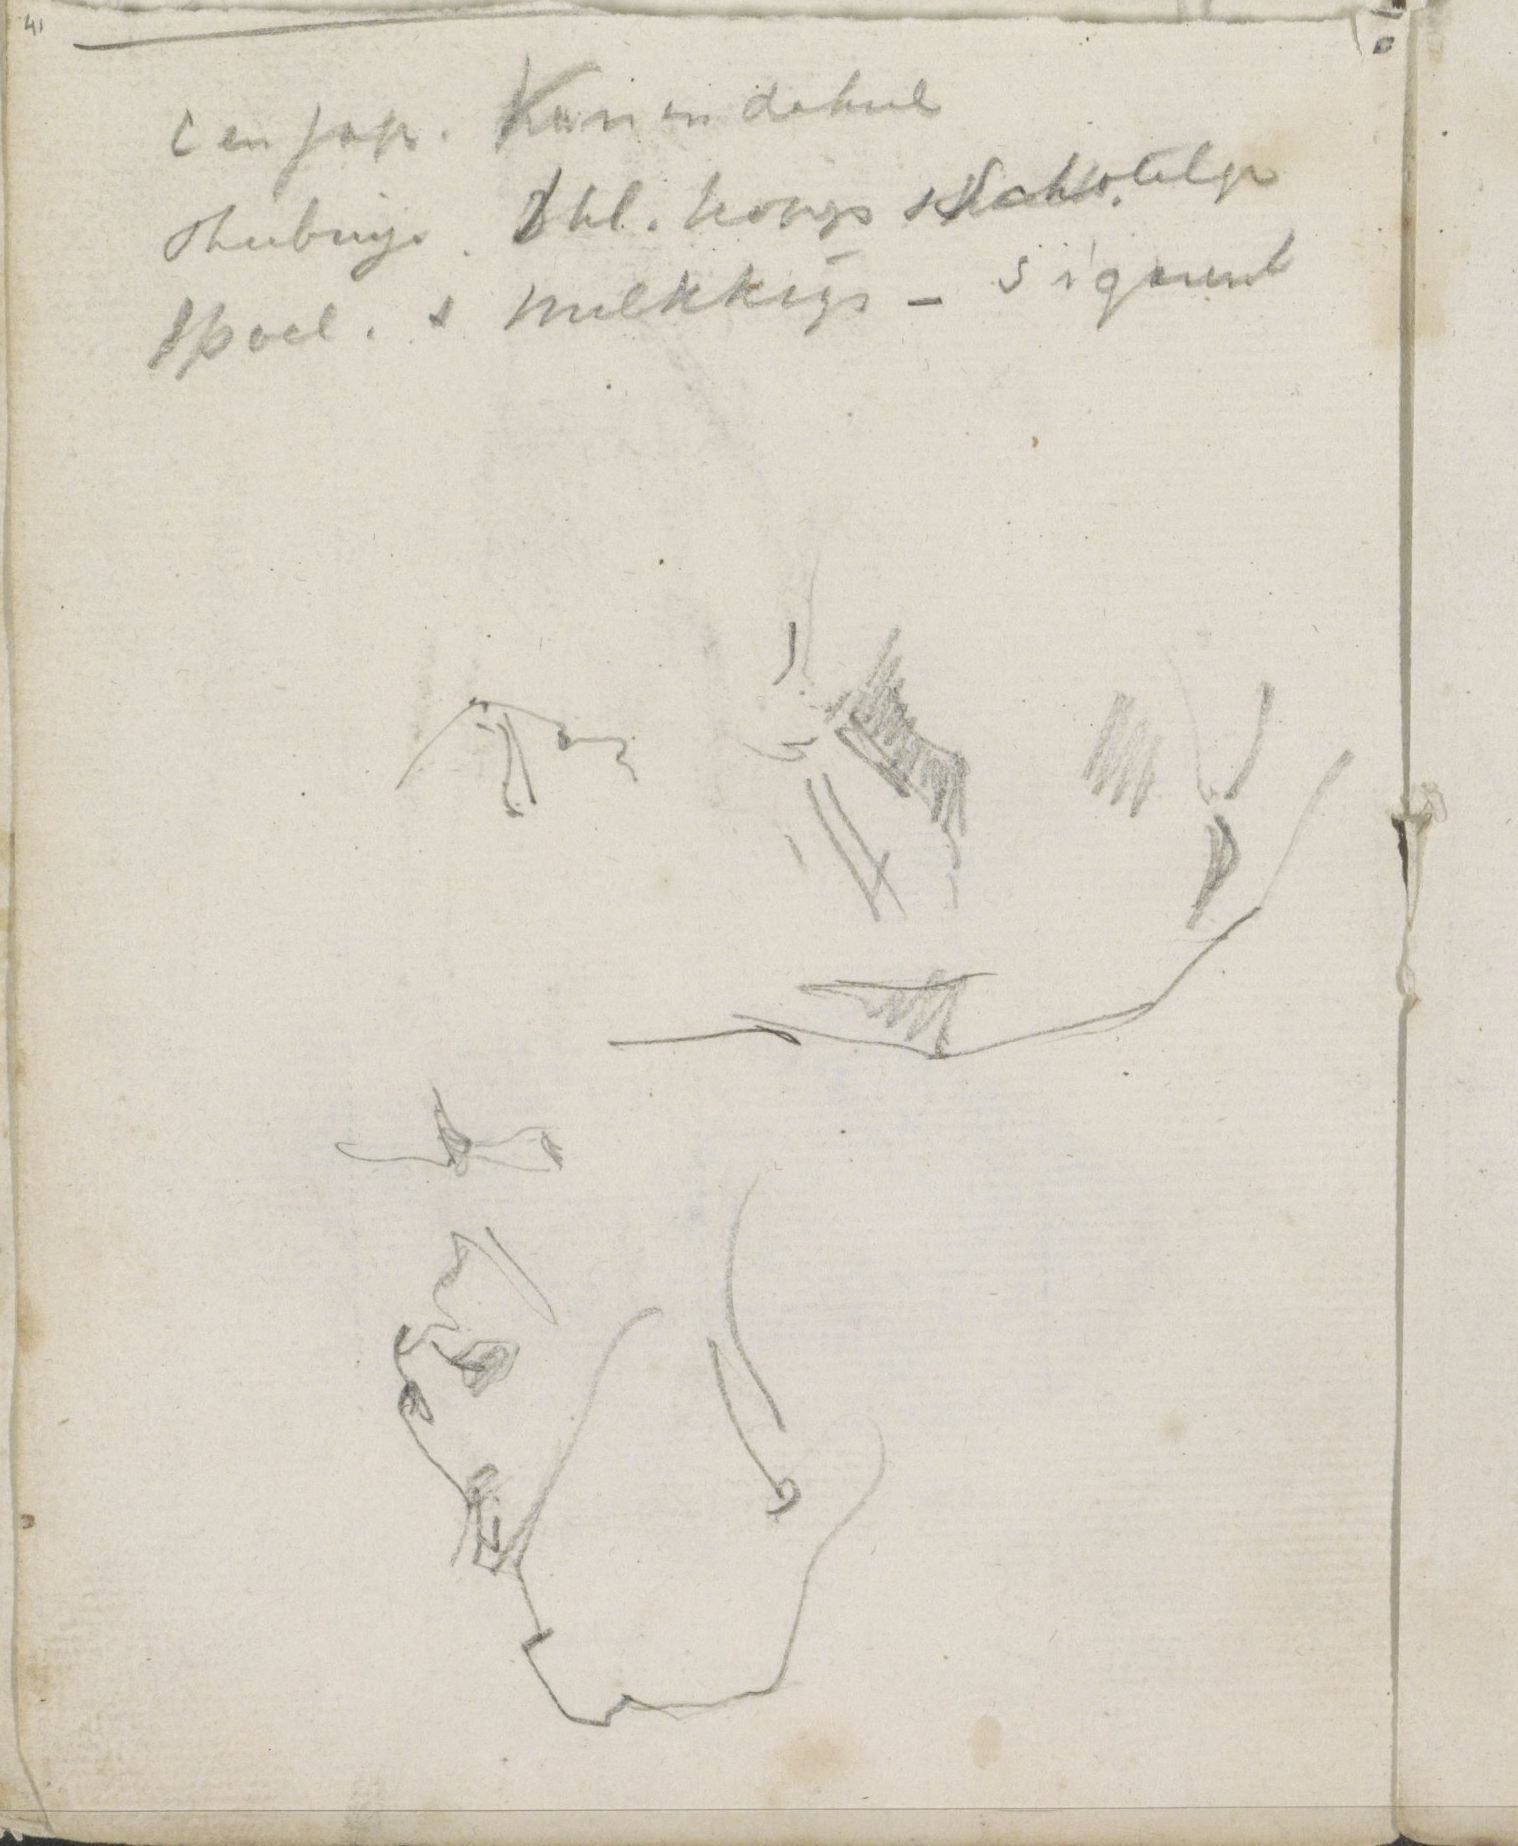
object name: sketchbook leaf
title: Studieblad, onder andere met een paard en gezichten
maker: george hendrik breitner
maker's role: draughtsman, painter, print maker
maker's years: 1857-1923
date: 1880-1882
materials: chalk, paper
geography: the hague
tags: face, horse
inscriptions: annotation: ‘[...]’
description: Pagina 41 uit een schetsboek met 29 bladen.